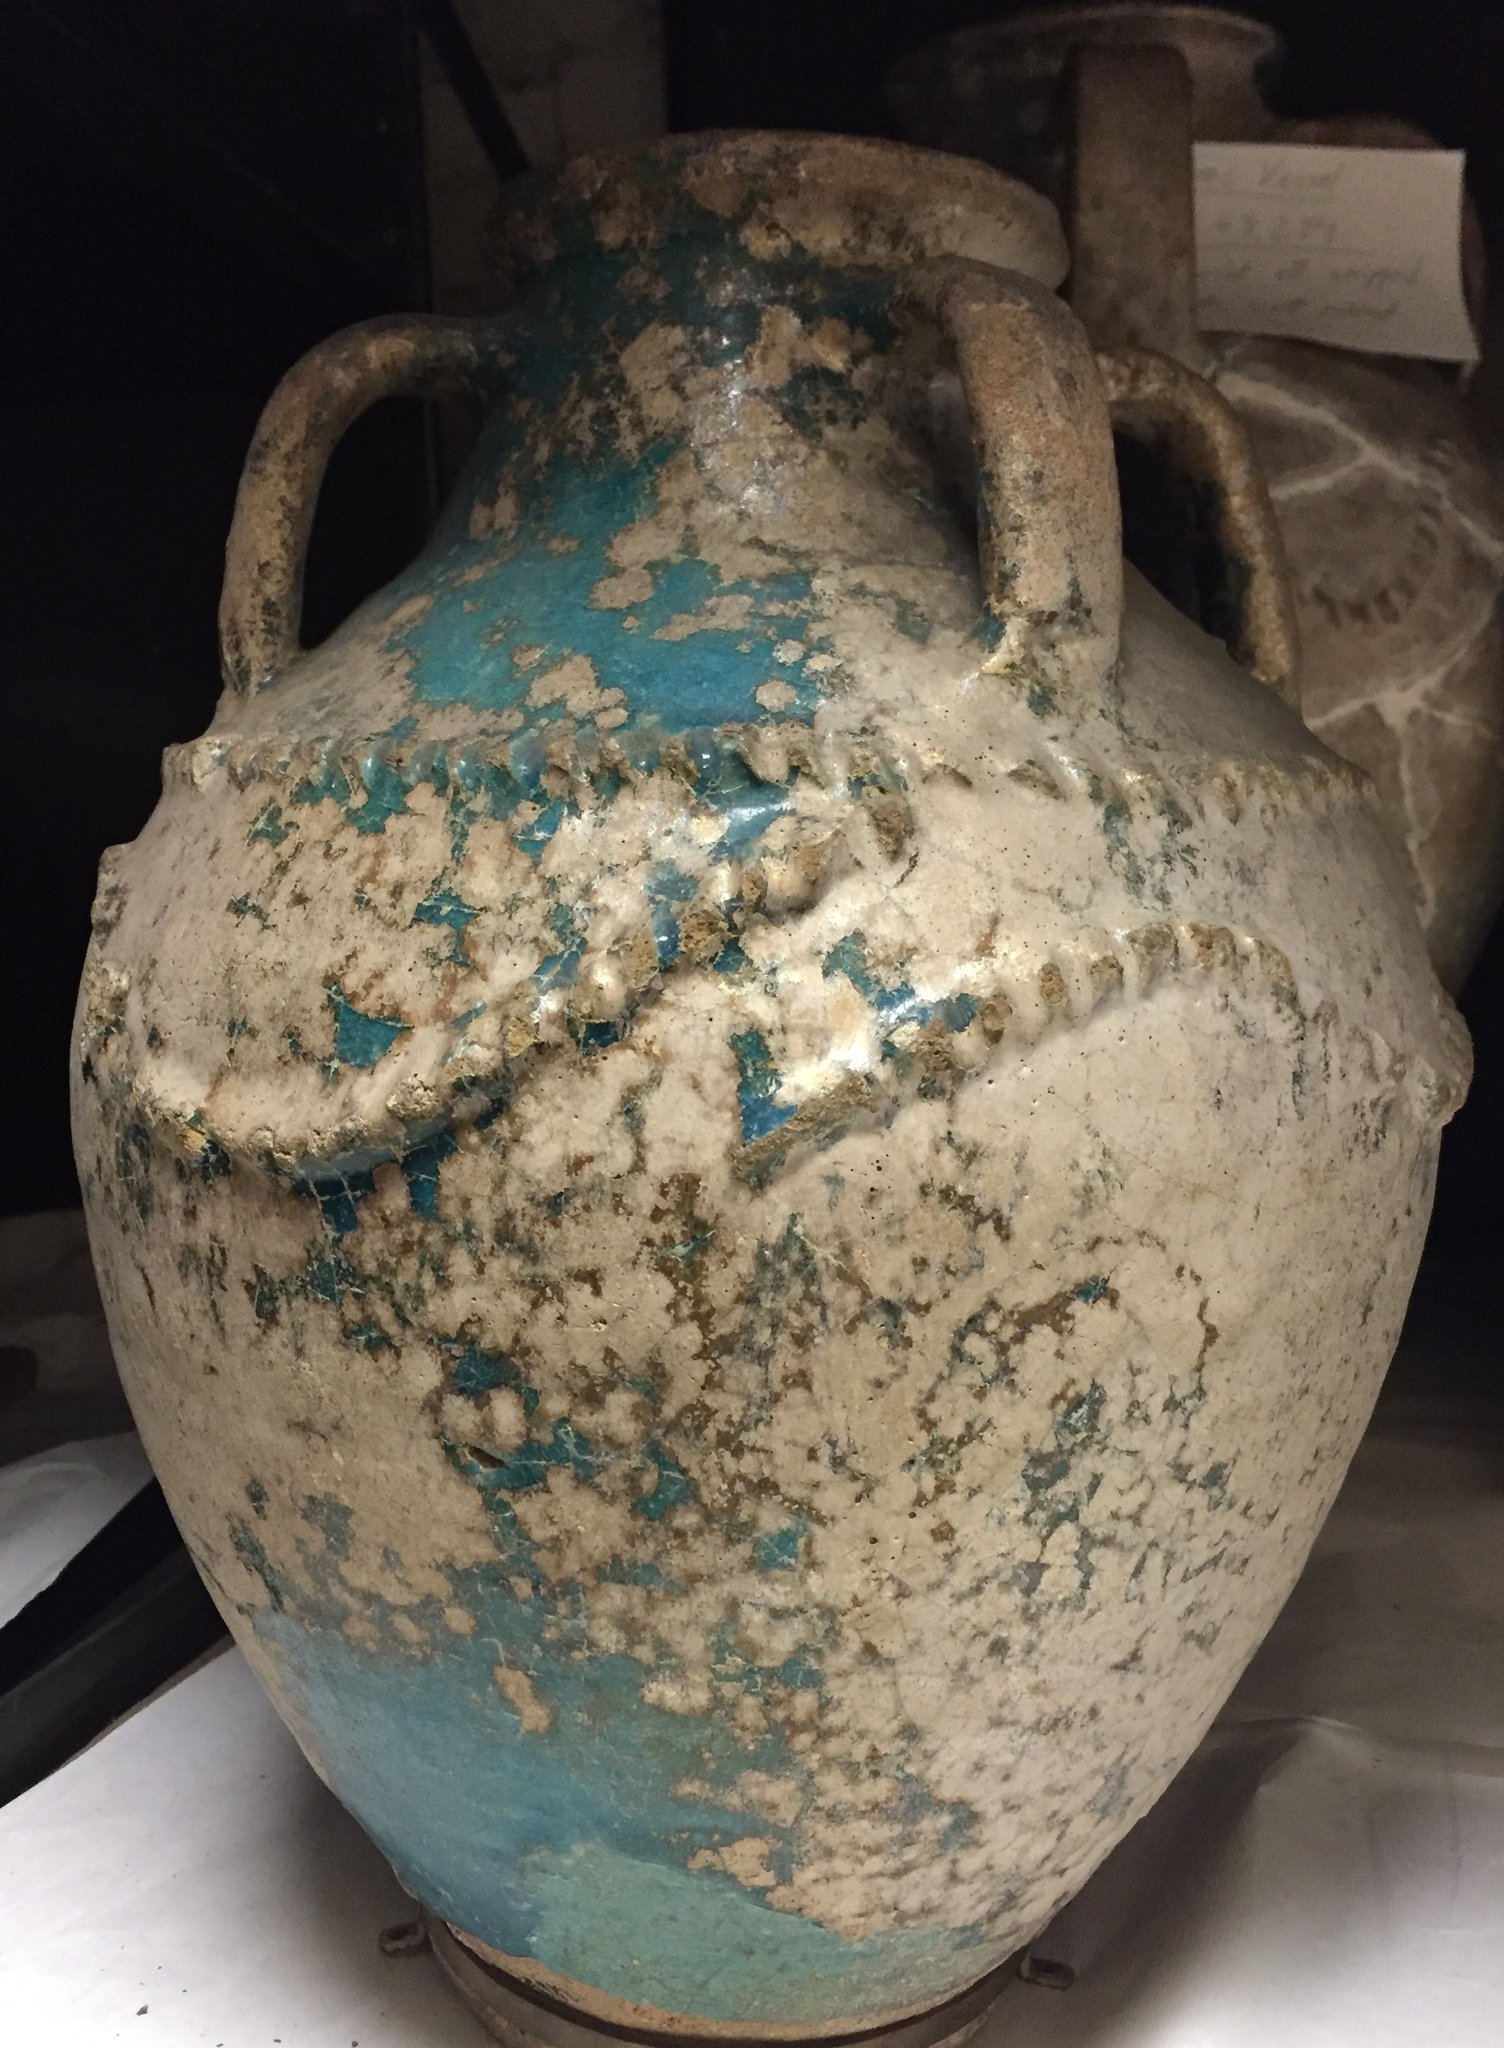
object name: jar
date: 1001-1200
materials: stonepaste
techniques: glazing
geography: syria